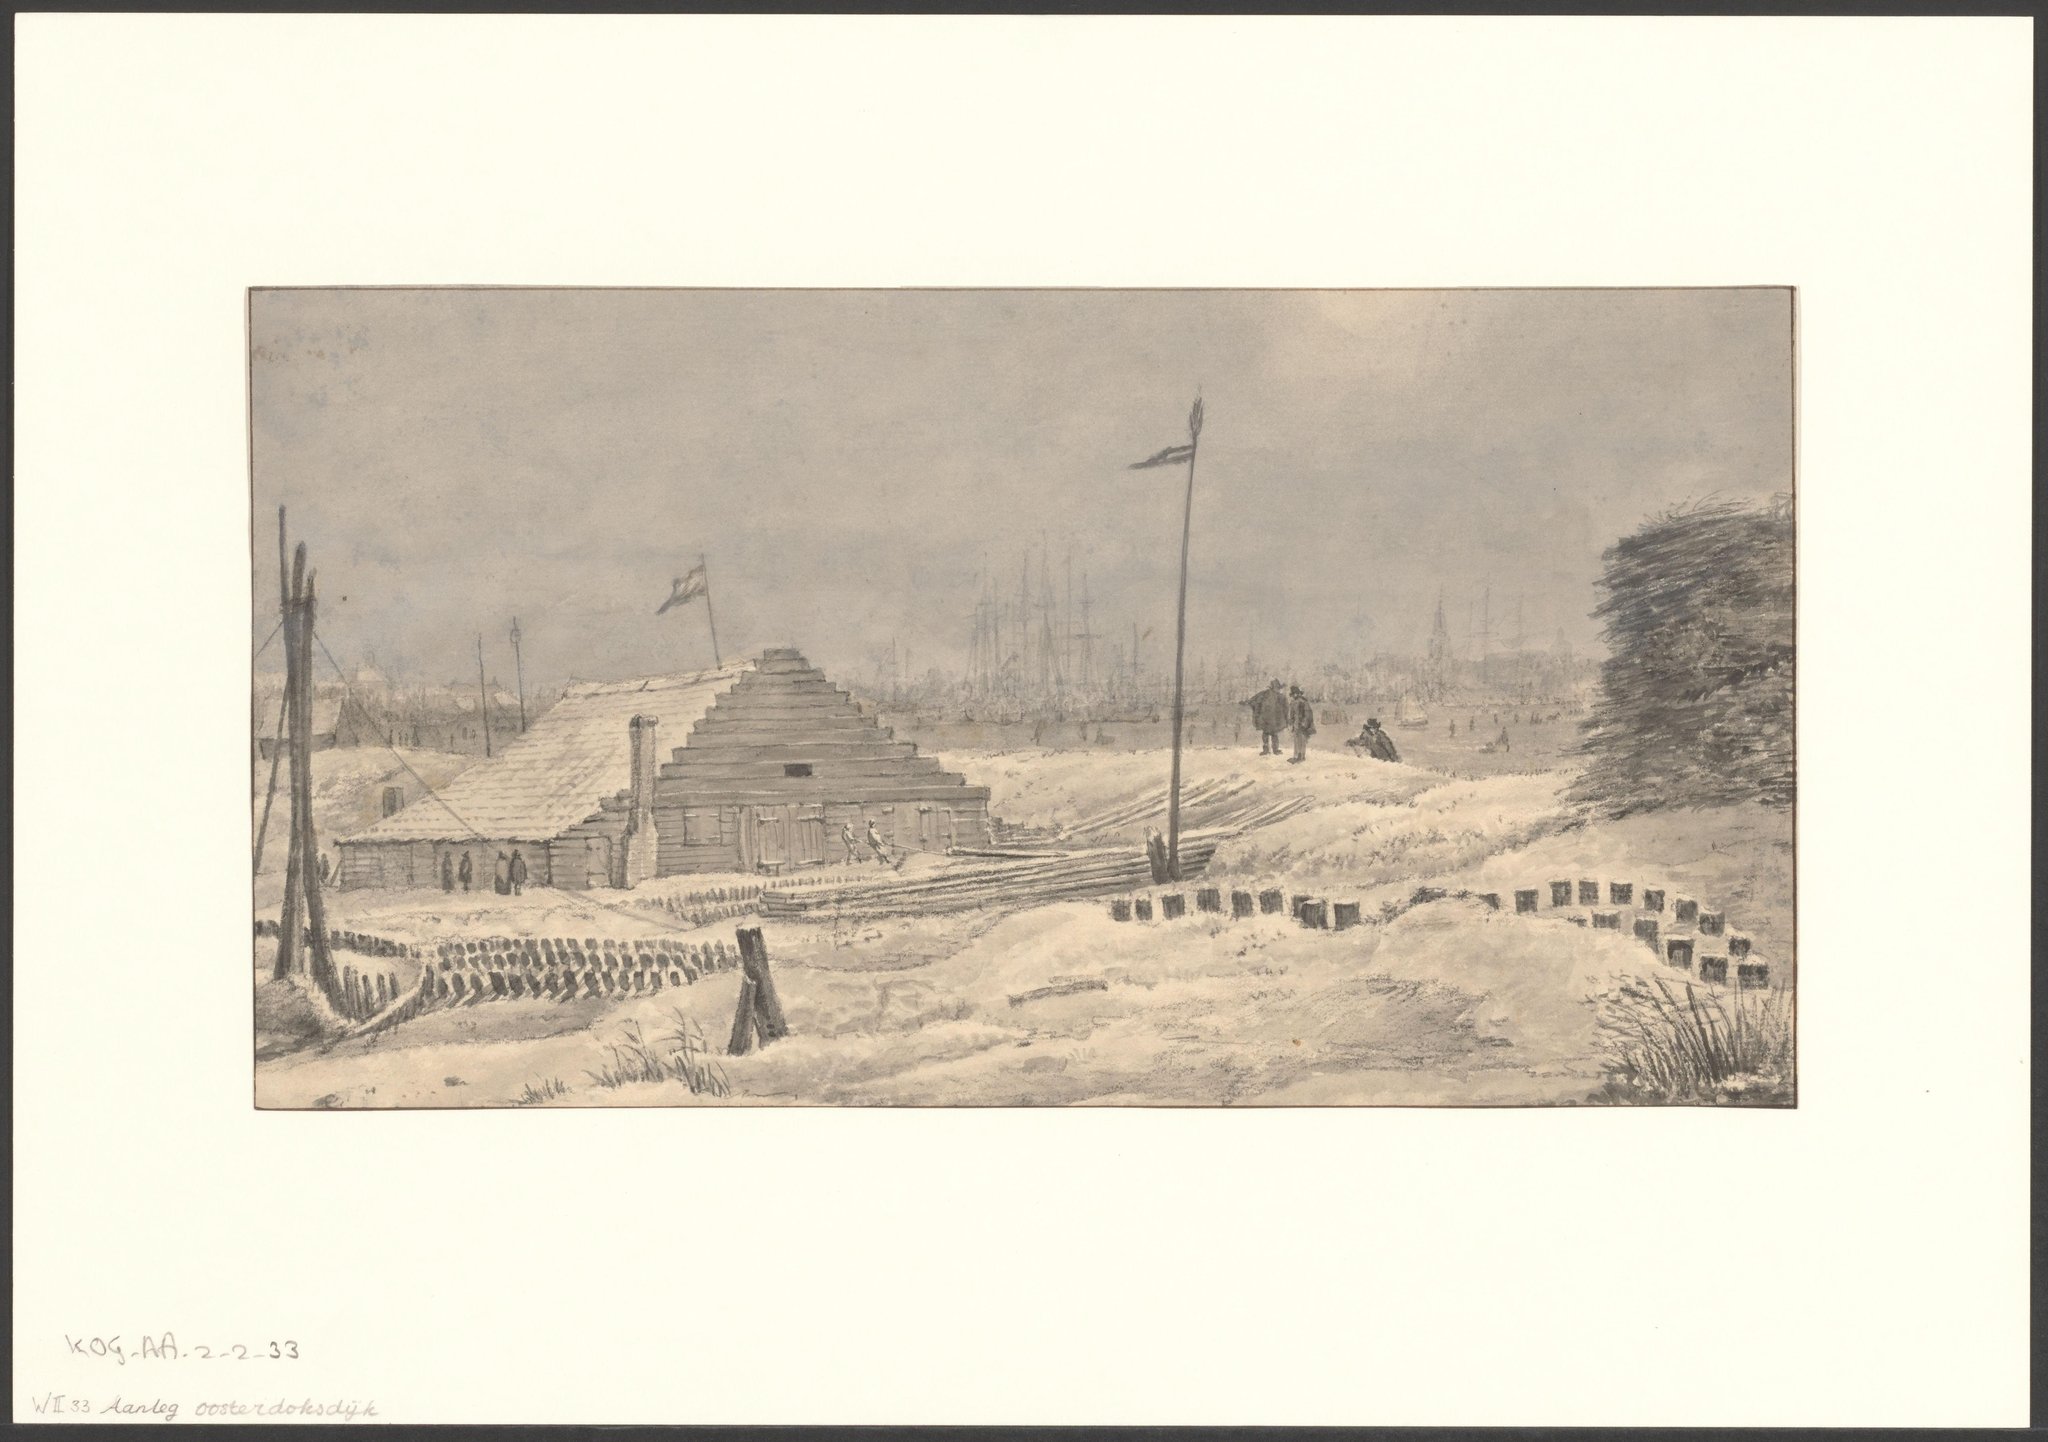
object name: drawing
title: Gezicht op de Oosterdoksdijk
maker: george pieter westenberg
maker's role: draughtsman, painter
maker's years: 1791-1873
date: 1801-1873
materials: paint, paper, pencil, watercolor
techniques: brush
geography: amsterdam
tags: city-view in general; 'veduta', river bank, farm or solitary house in landscape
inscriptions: collector's mark: Lugt 800a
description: Tekening binnen de Atlas Van Eck ingedeeld op wijknummer 2.